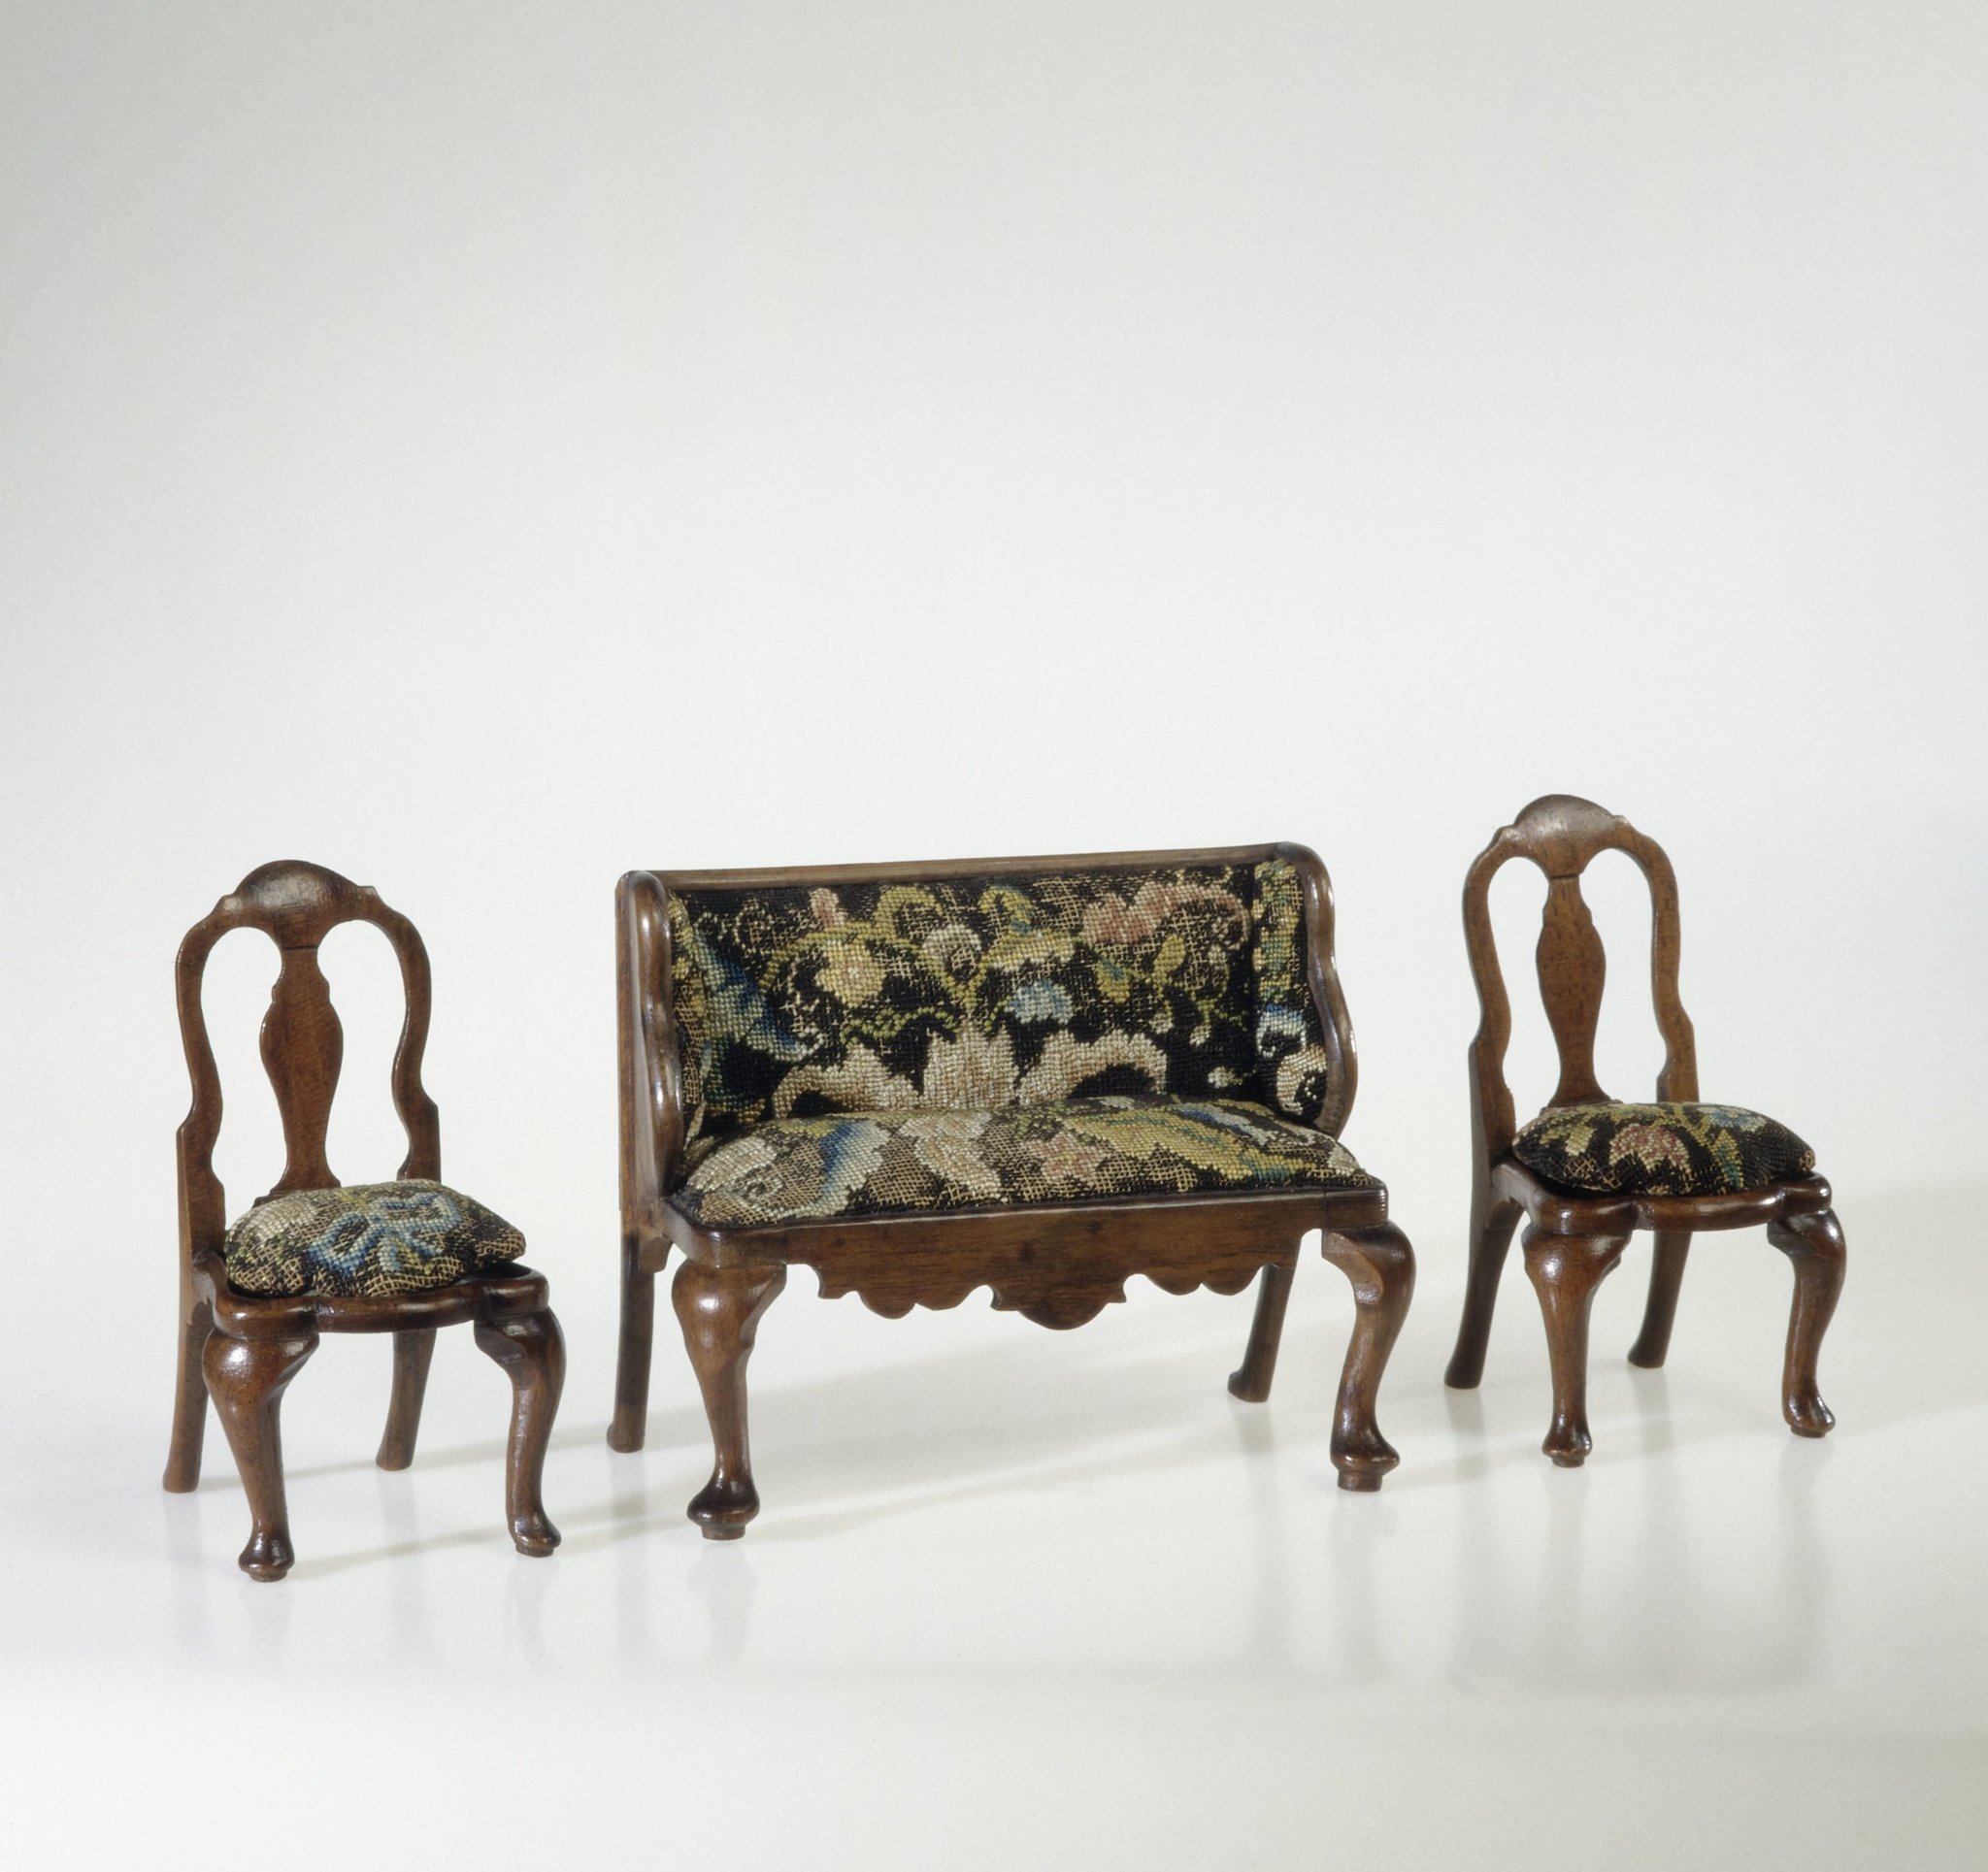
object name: miniature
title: Stoel, behorend tot een elfdelig ameublement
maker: Anonymous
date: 1750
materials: silk, wood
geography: amsterdam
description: Stoel, vervaardigd van notenhout, behorend tot een elfdelig ameublement, bestaande uit een bank en tien stoelen. De zitting van buurduurwerk met blad- en bloemmotieven in zijde op linnen stramien, met een zachte vulling.